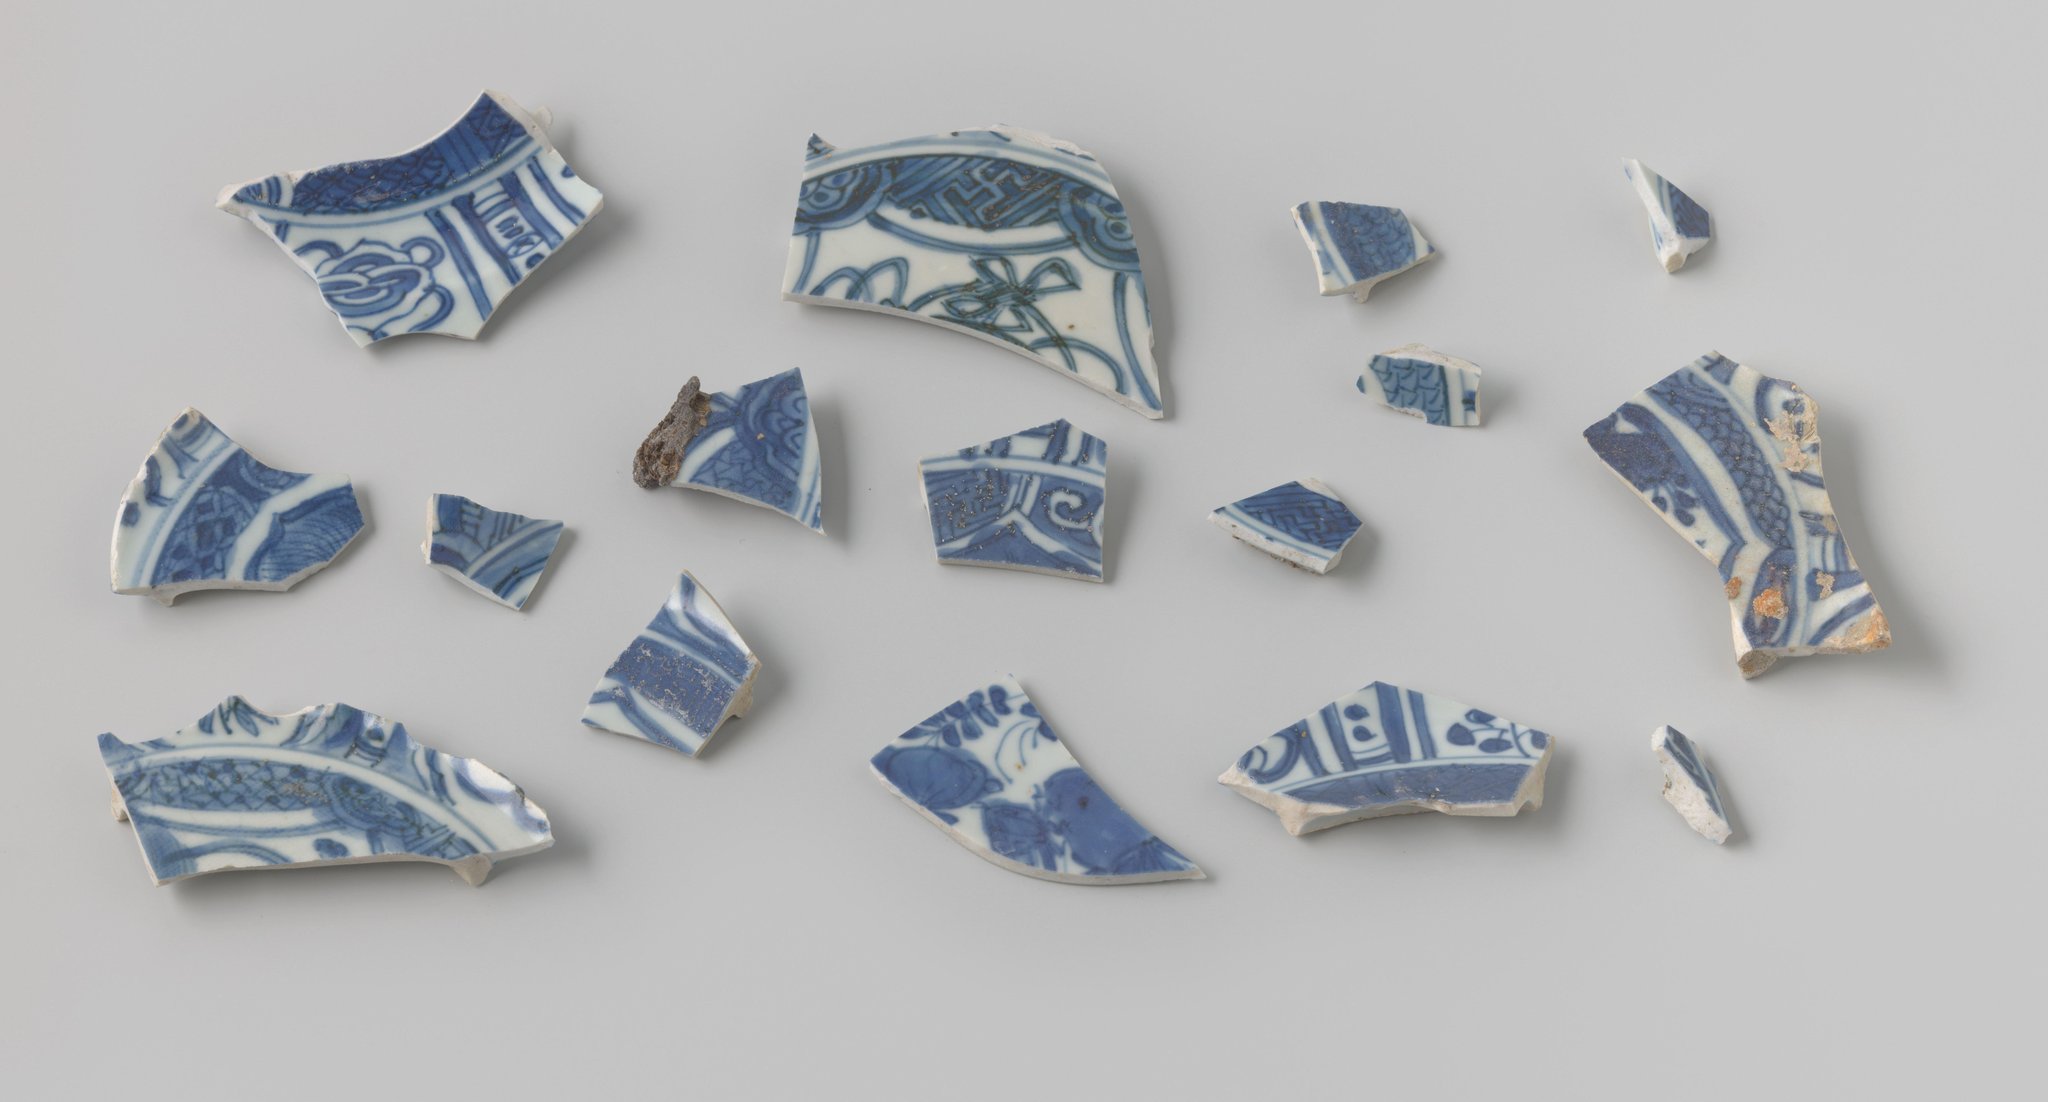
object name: plate dish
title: Scherven van borden uit V.O.C.-schip de 'Witte Leeuw'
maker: Anonymous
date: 1613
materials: bone china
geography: jingdezhen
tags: verenigde oostindische compagnie, sint-helena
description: Scherven kraakporselein van borden uit V.O.C.-schip de 'Witte Leeuw'.